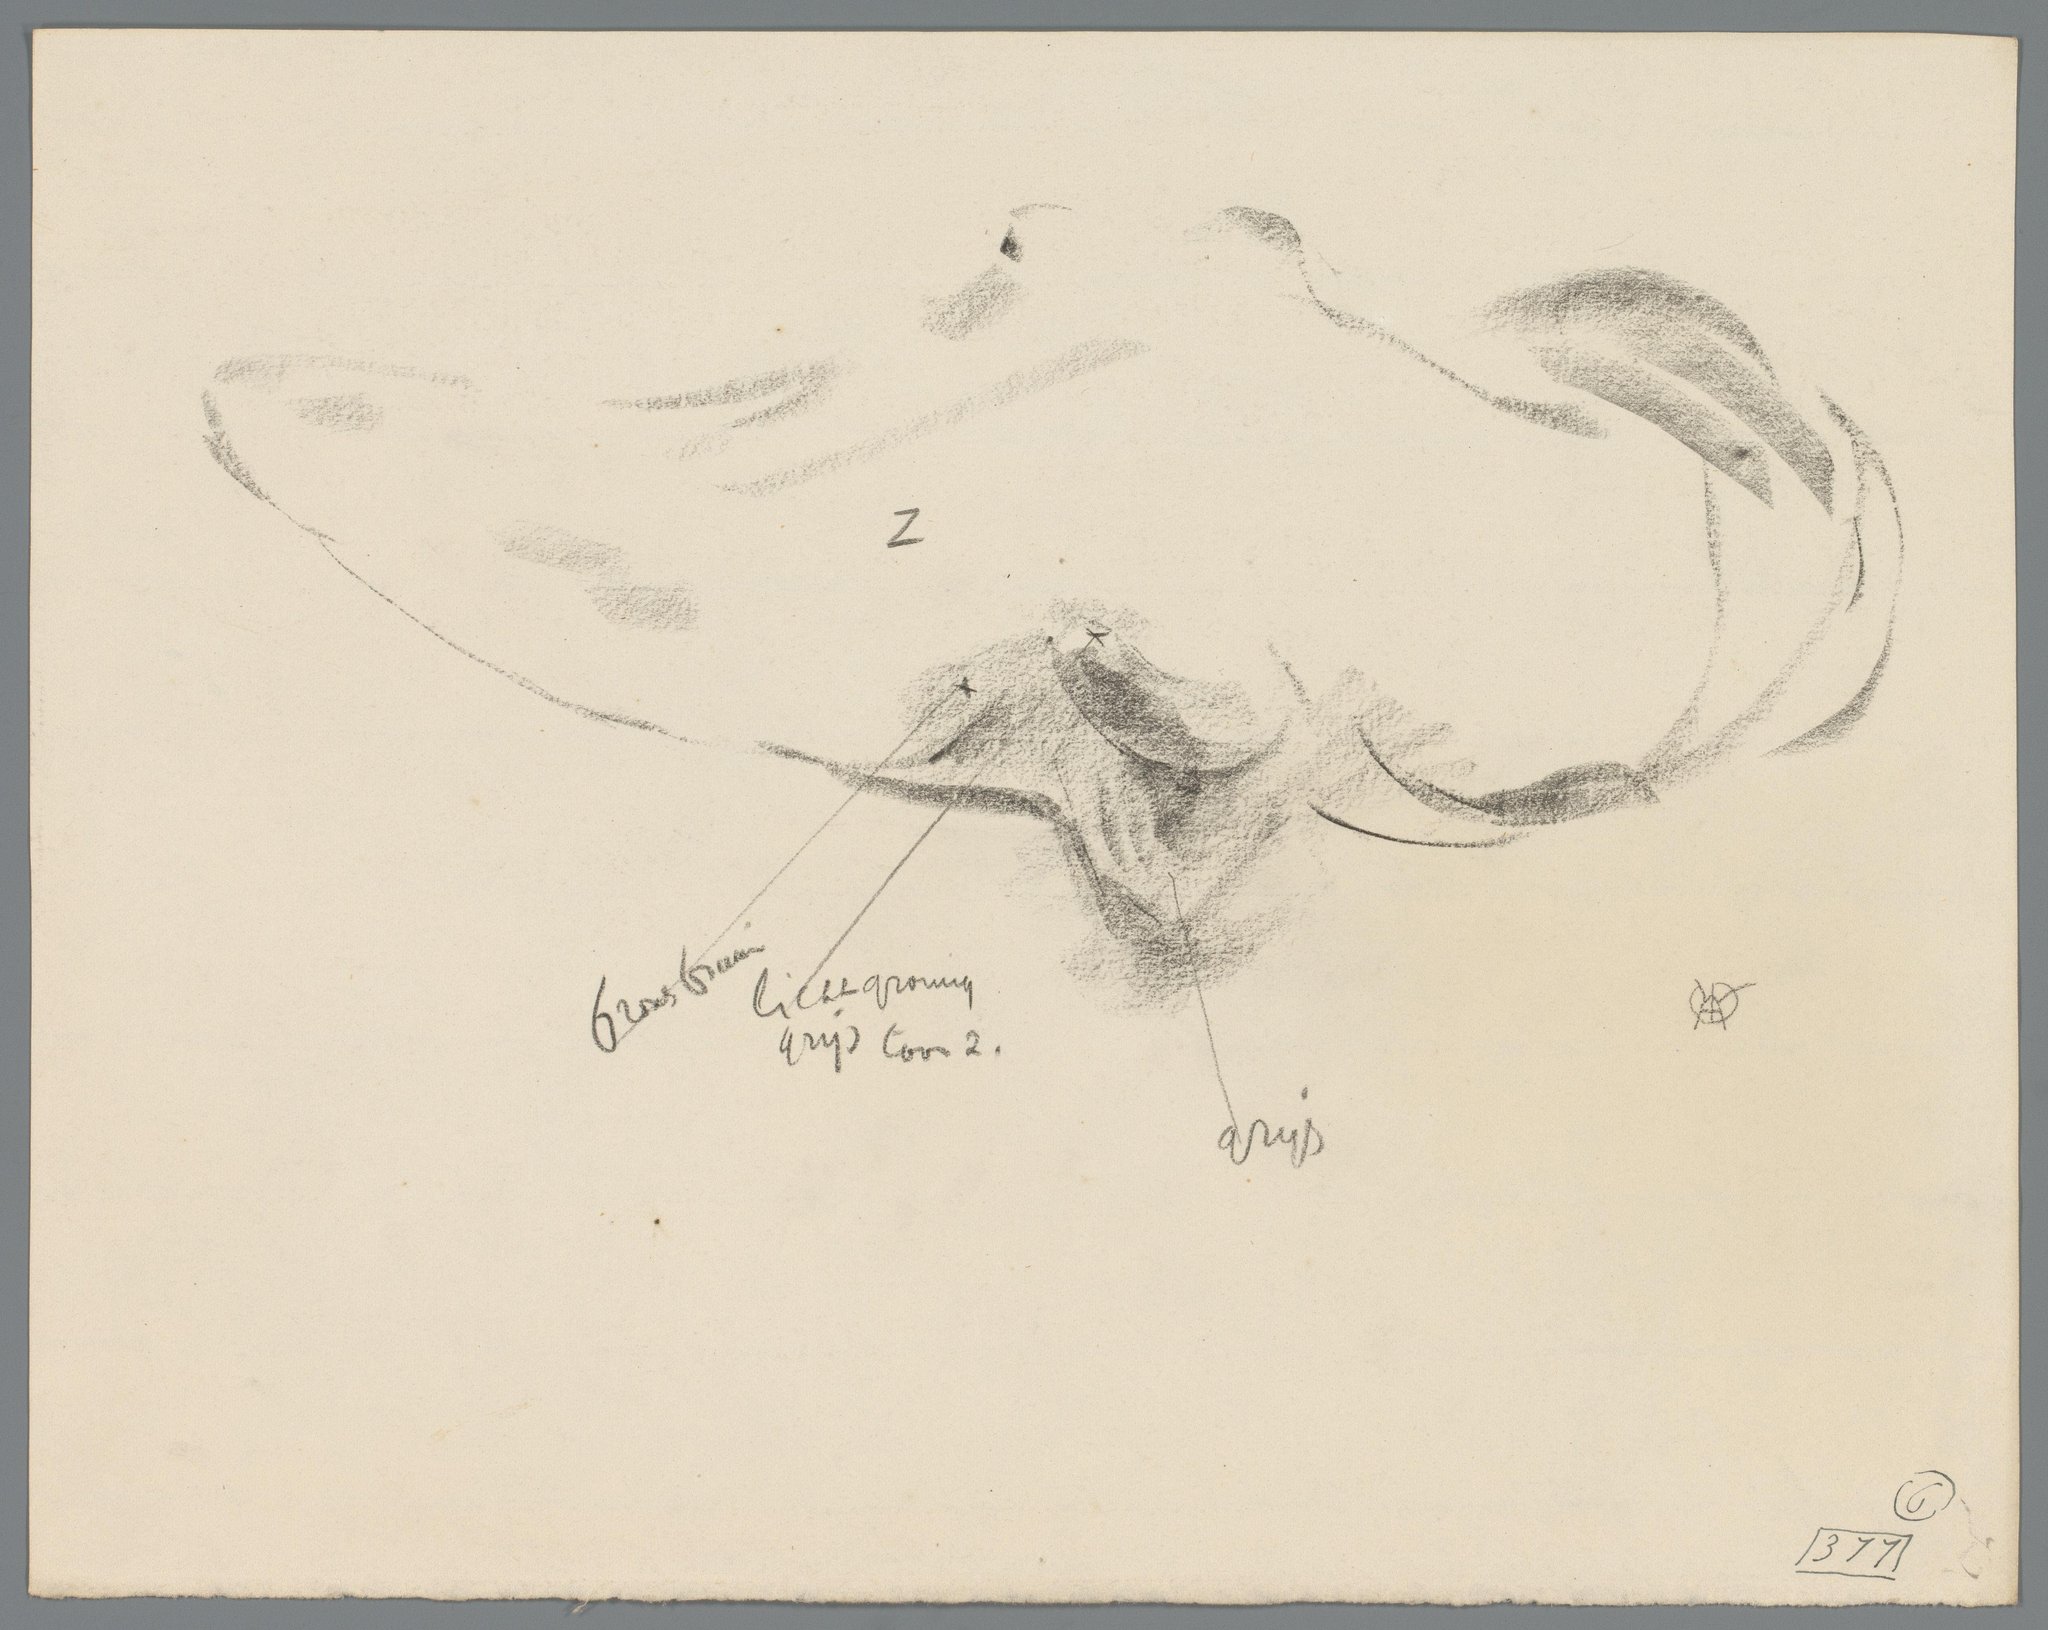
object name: drawing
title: Studie van een rog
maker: gerrit willem dijsselhof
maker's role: designer, draughtsman, print maker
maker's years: 1866-1924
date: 1876-1924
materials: chalk, paper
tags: cartilaginous fishes: ray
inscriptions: number: ‘6’, number: ‘377’